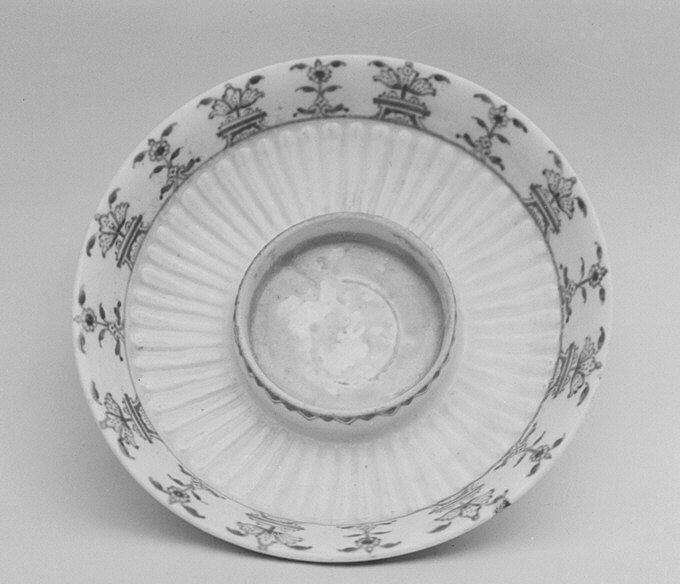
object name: saucer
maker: saint-cloud factory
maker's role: factory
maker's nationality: french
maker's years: 1693-1766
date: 1700-1720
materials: soft paste porcelain